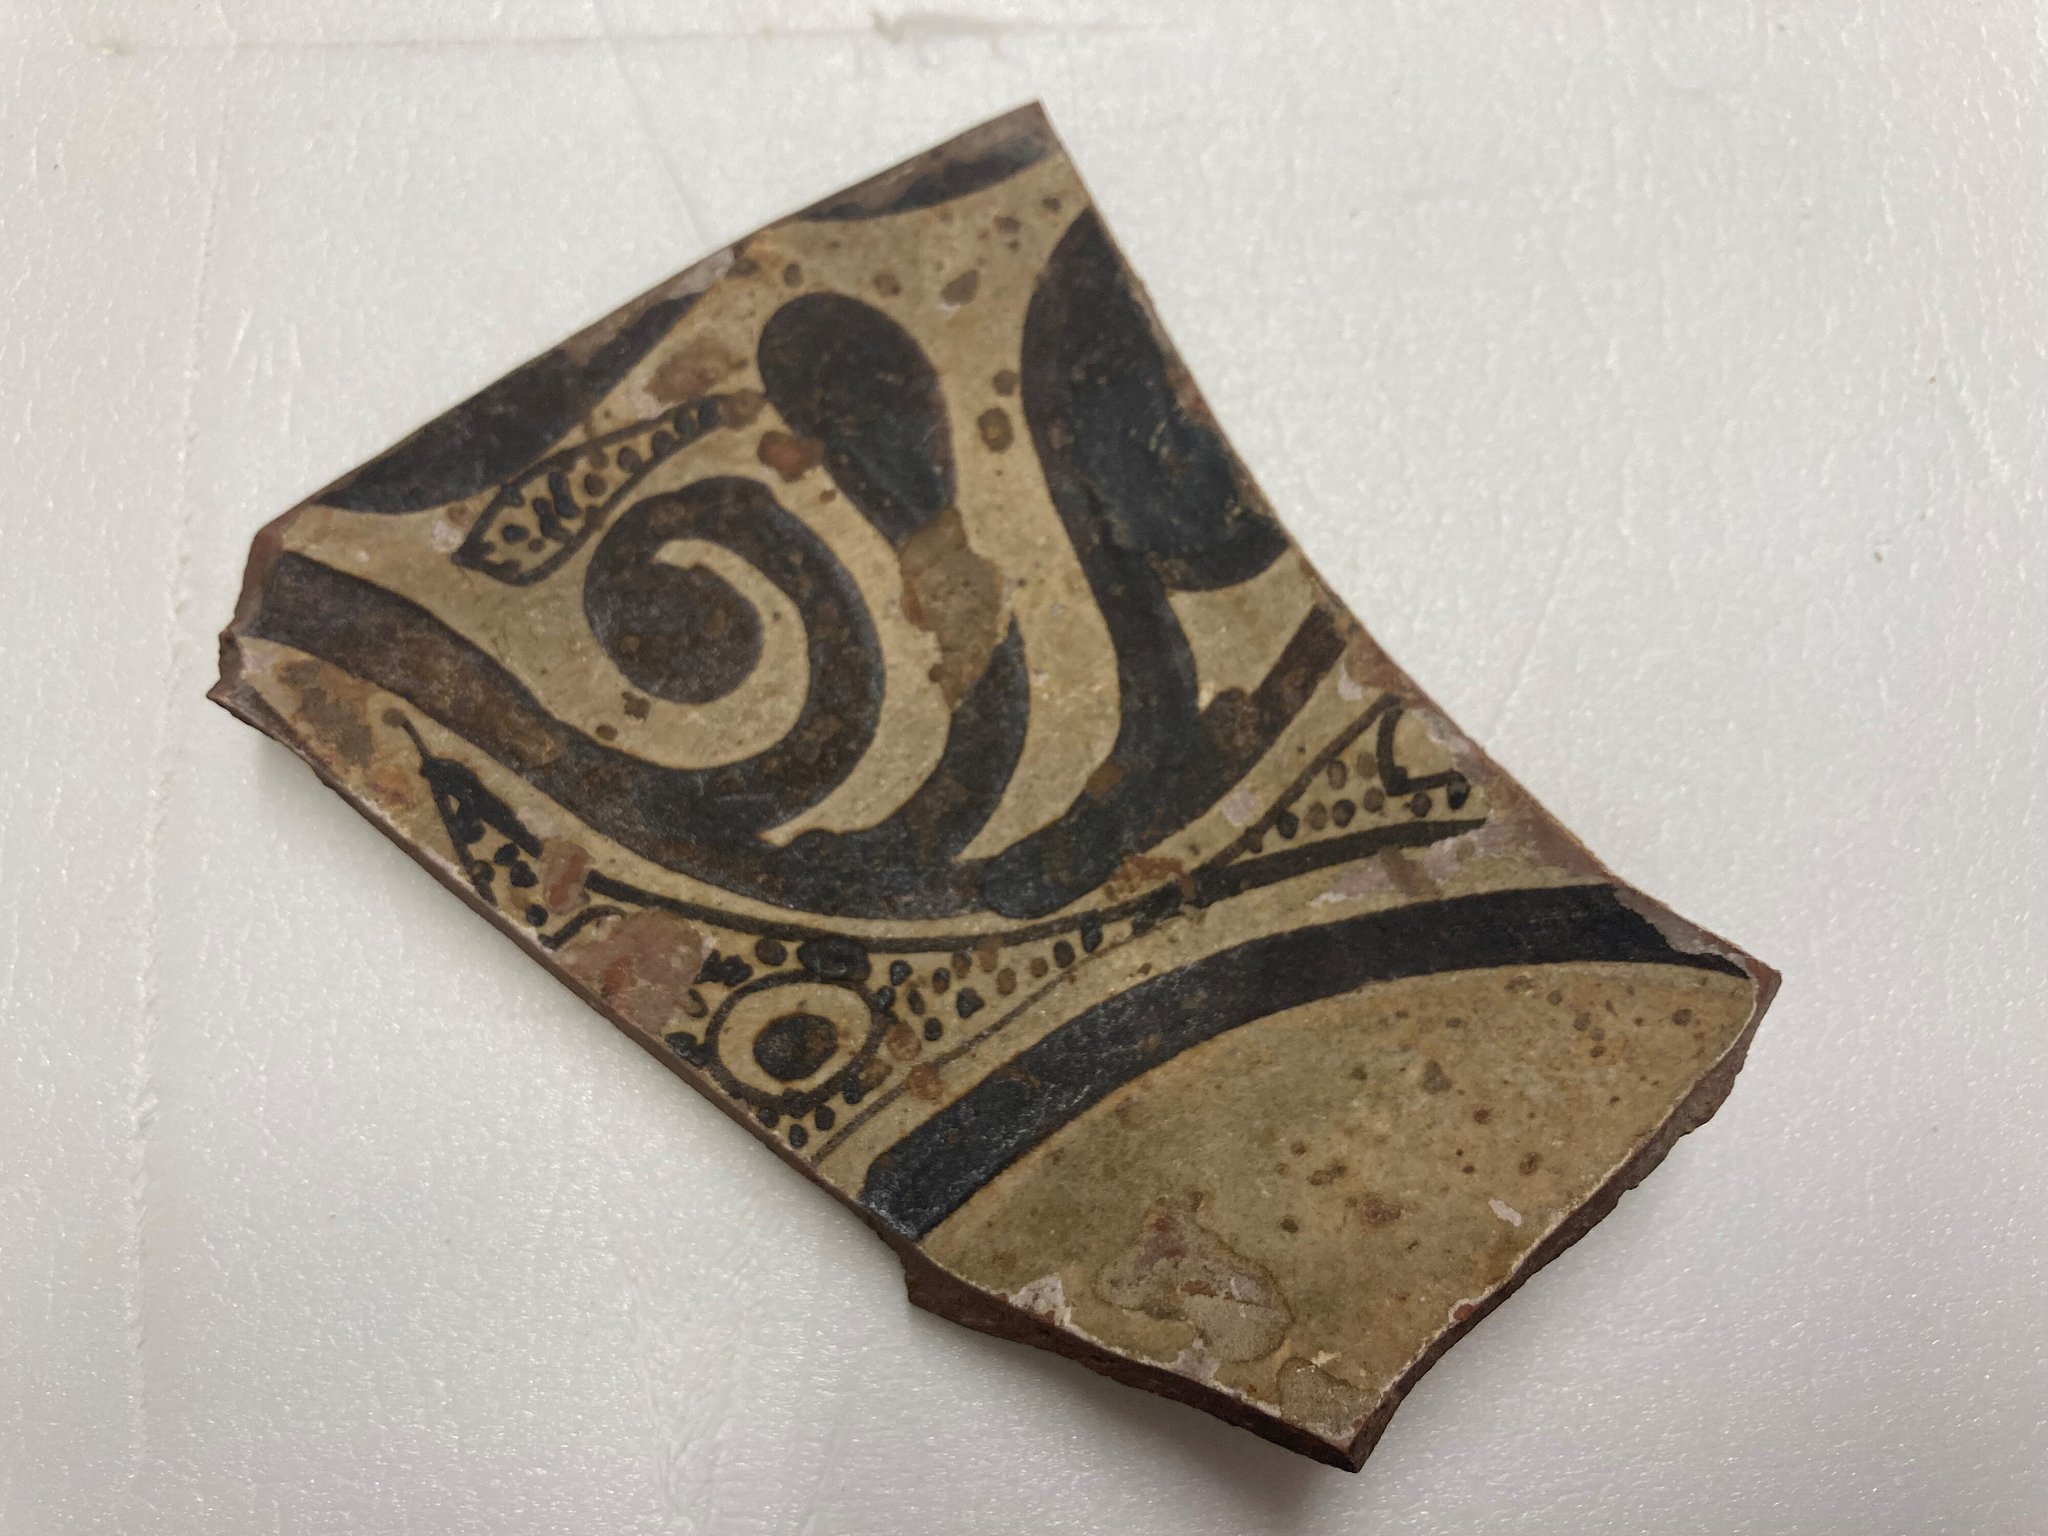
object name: fragment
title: Fragment of a Bowl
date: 801-900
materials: earthenware, glaze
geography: iran